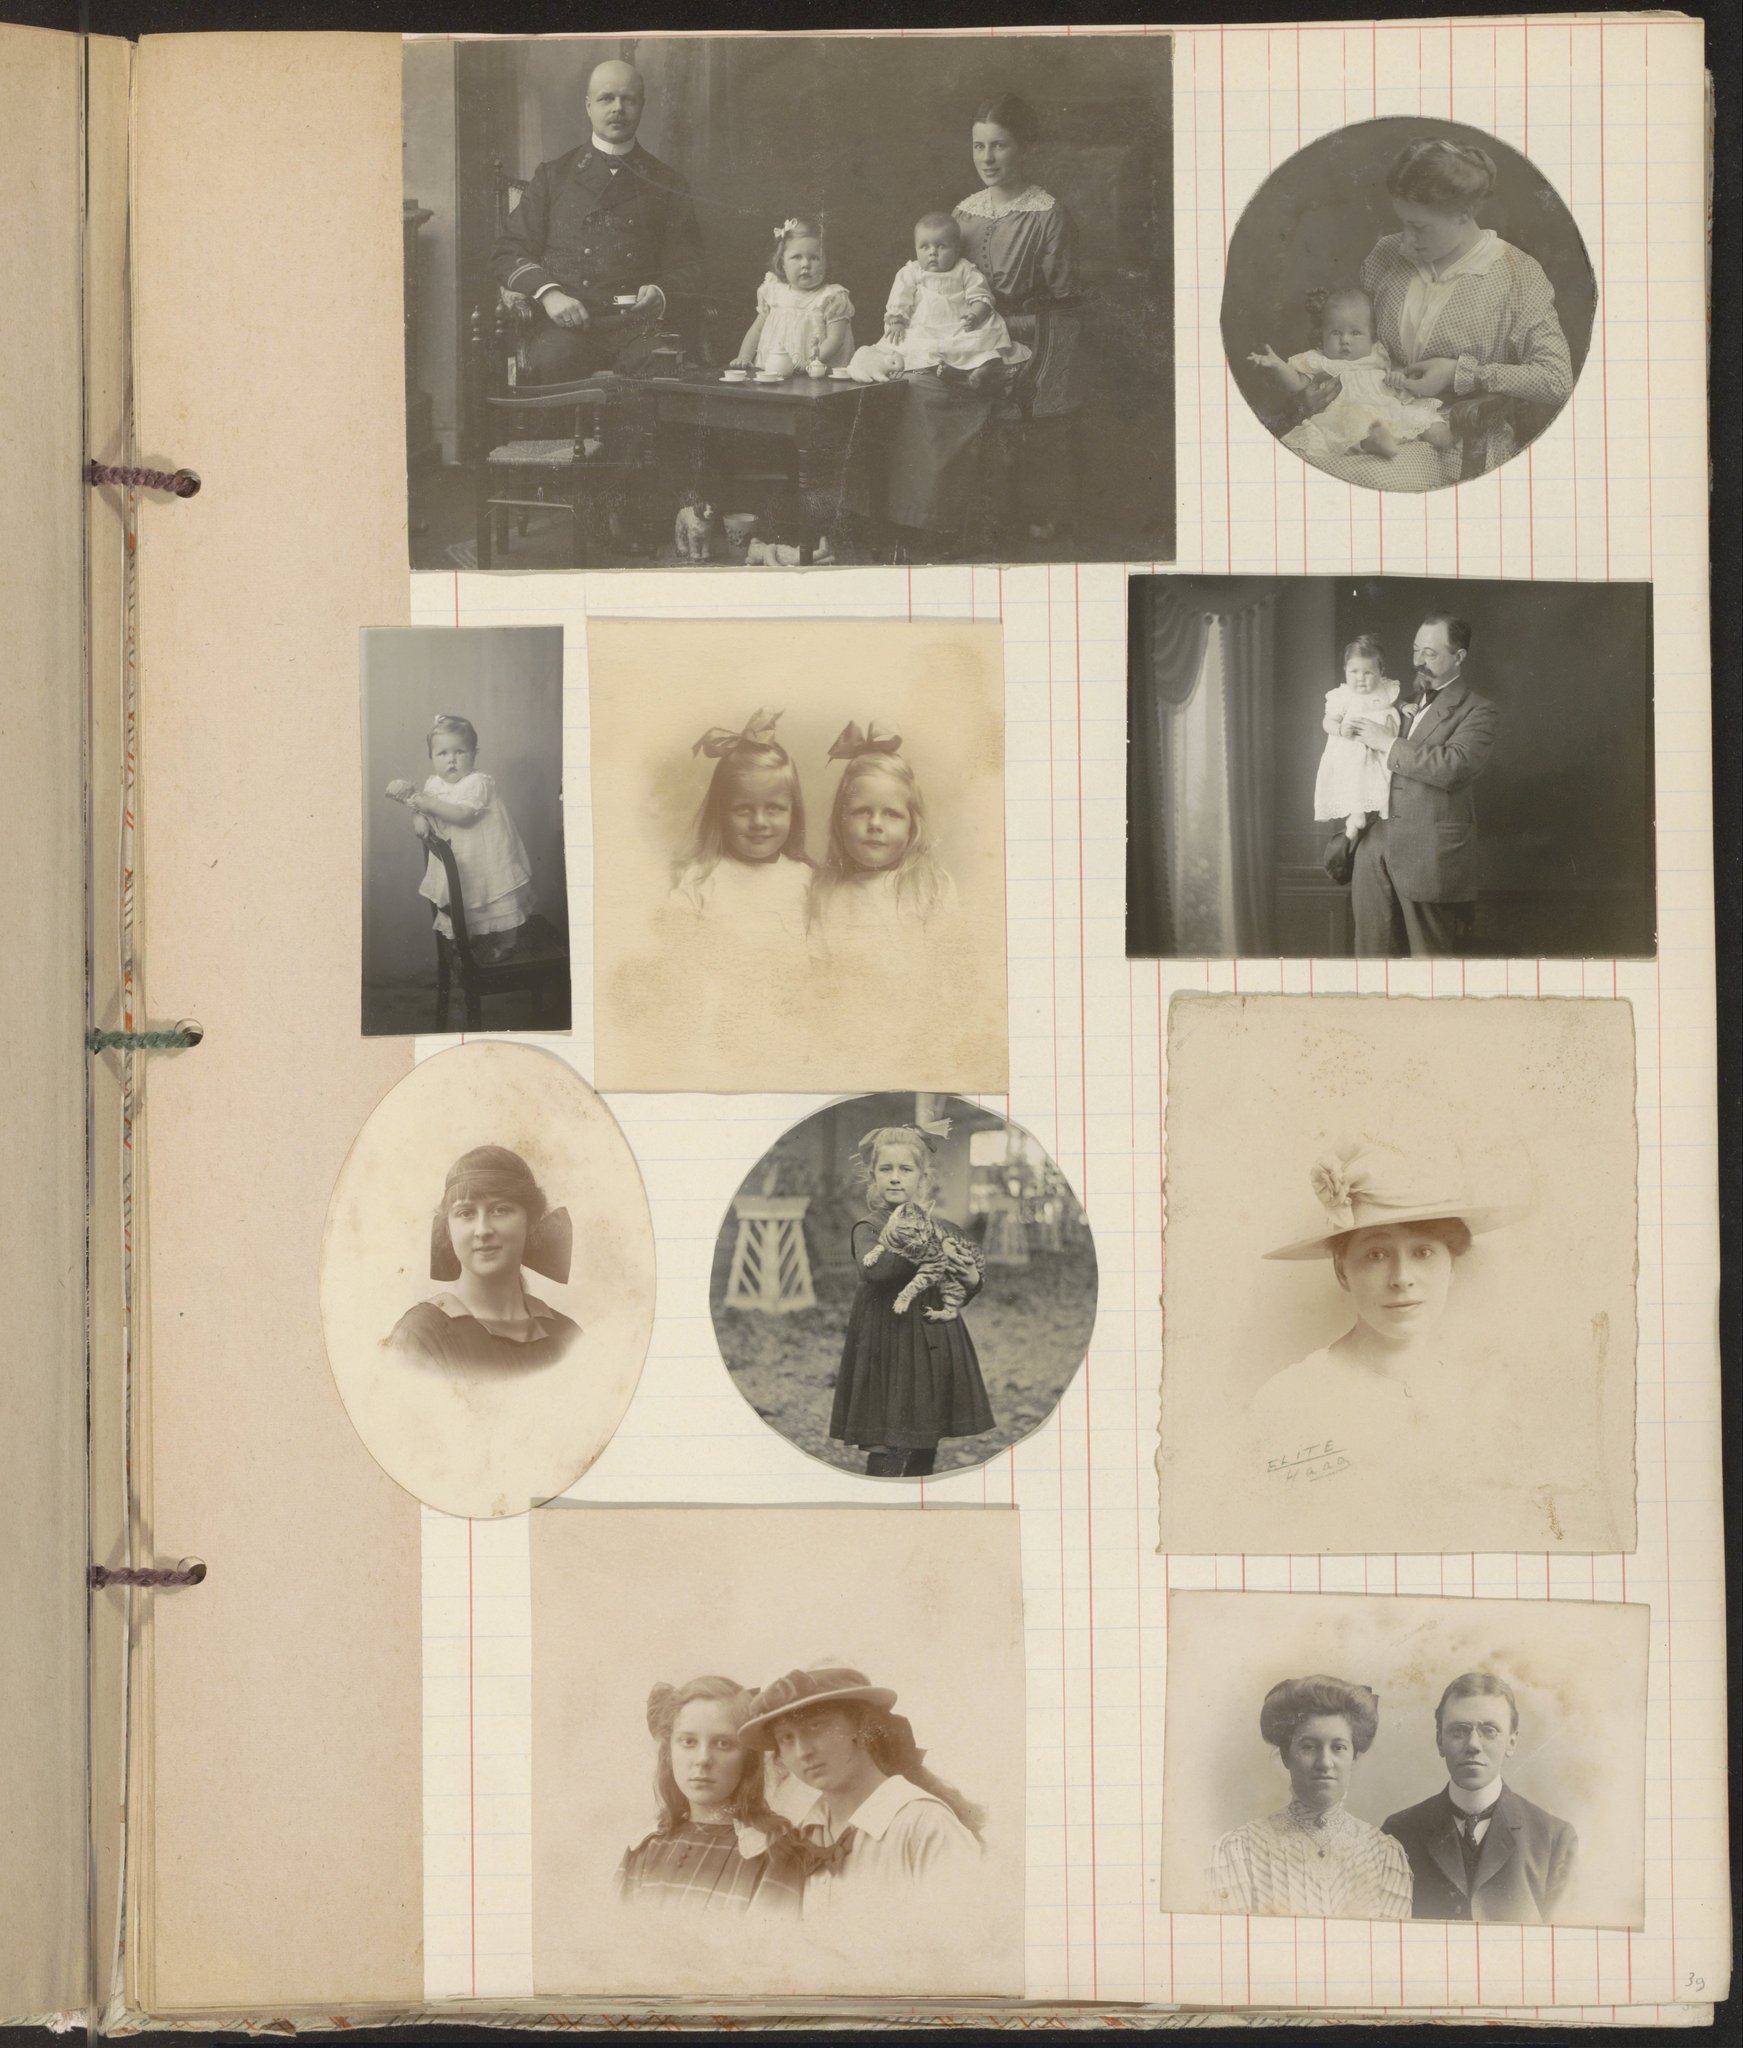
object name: photograph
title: Portretten van onbekende personen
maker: Anonymous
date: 1910-1930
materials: paper, photographic support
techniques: gelatin silver print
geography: netherlands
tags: adult woman, parents with their children, cat, adult man, child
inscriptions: inscription: ‘Elite [...]’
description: Albumblad met portretten van volwassenen en kinderen. Onderdeel van Fotoalbum van de familie Petri.